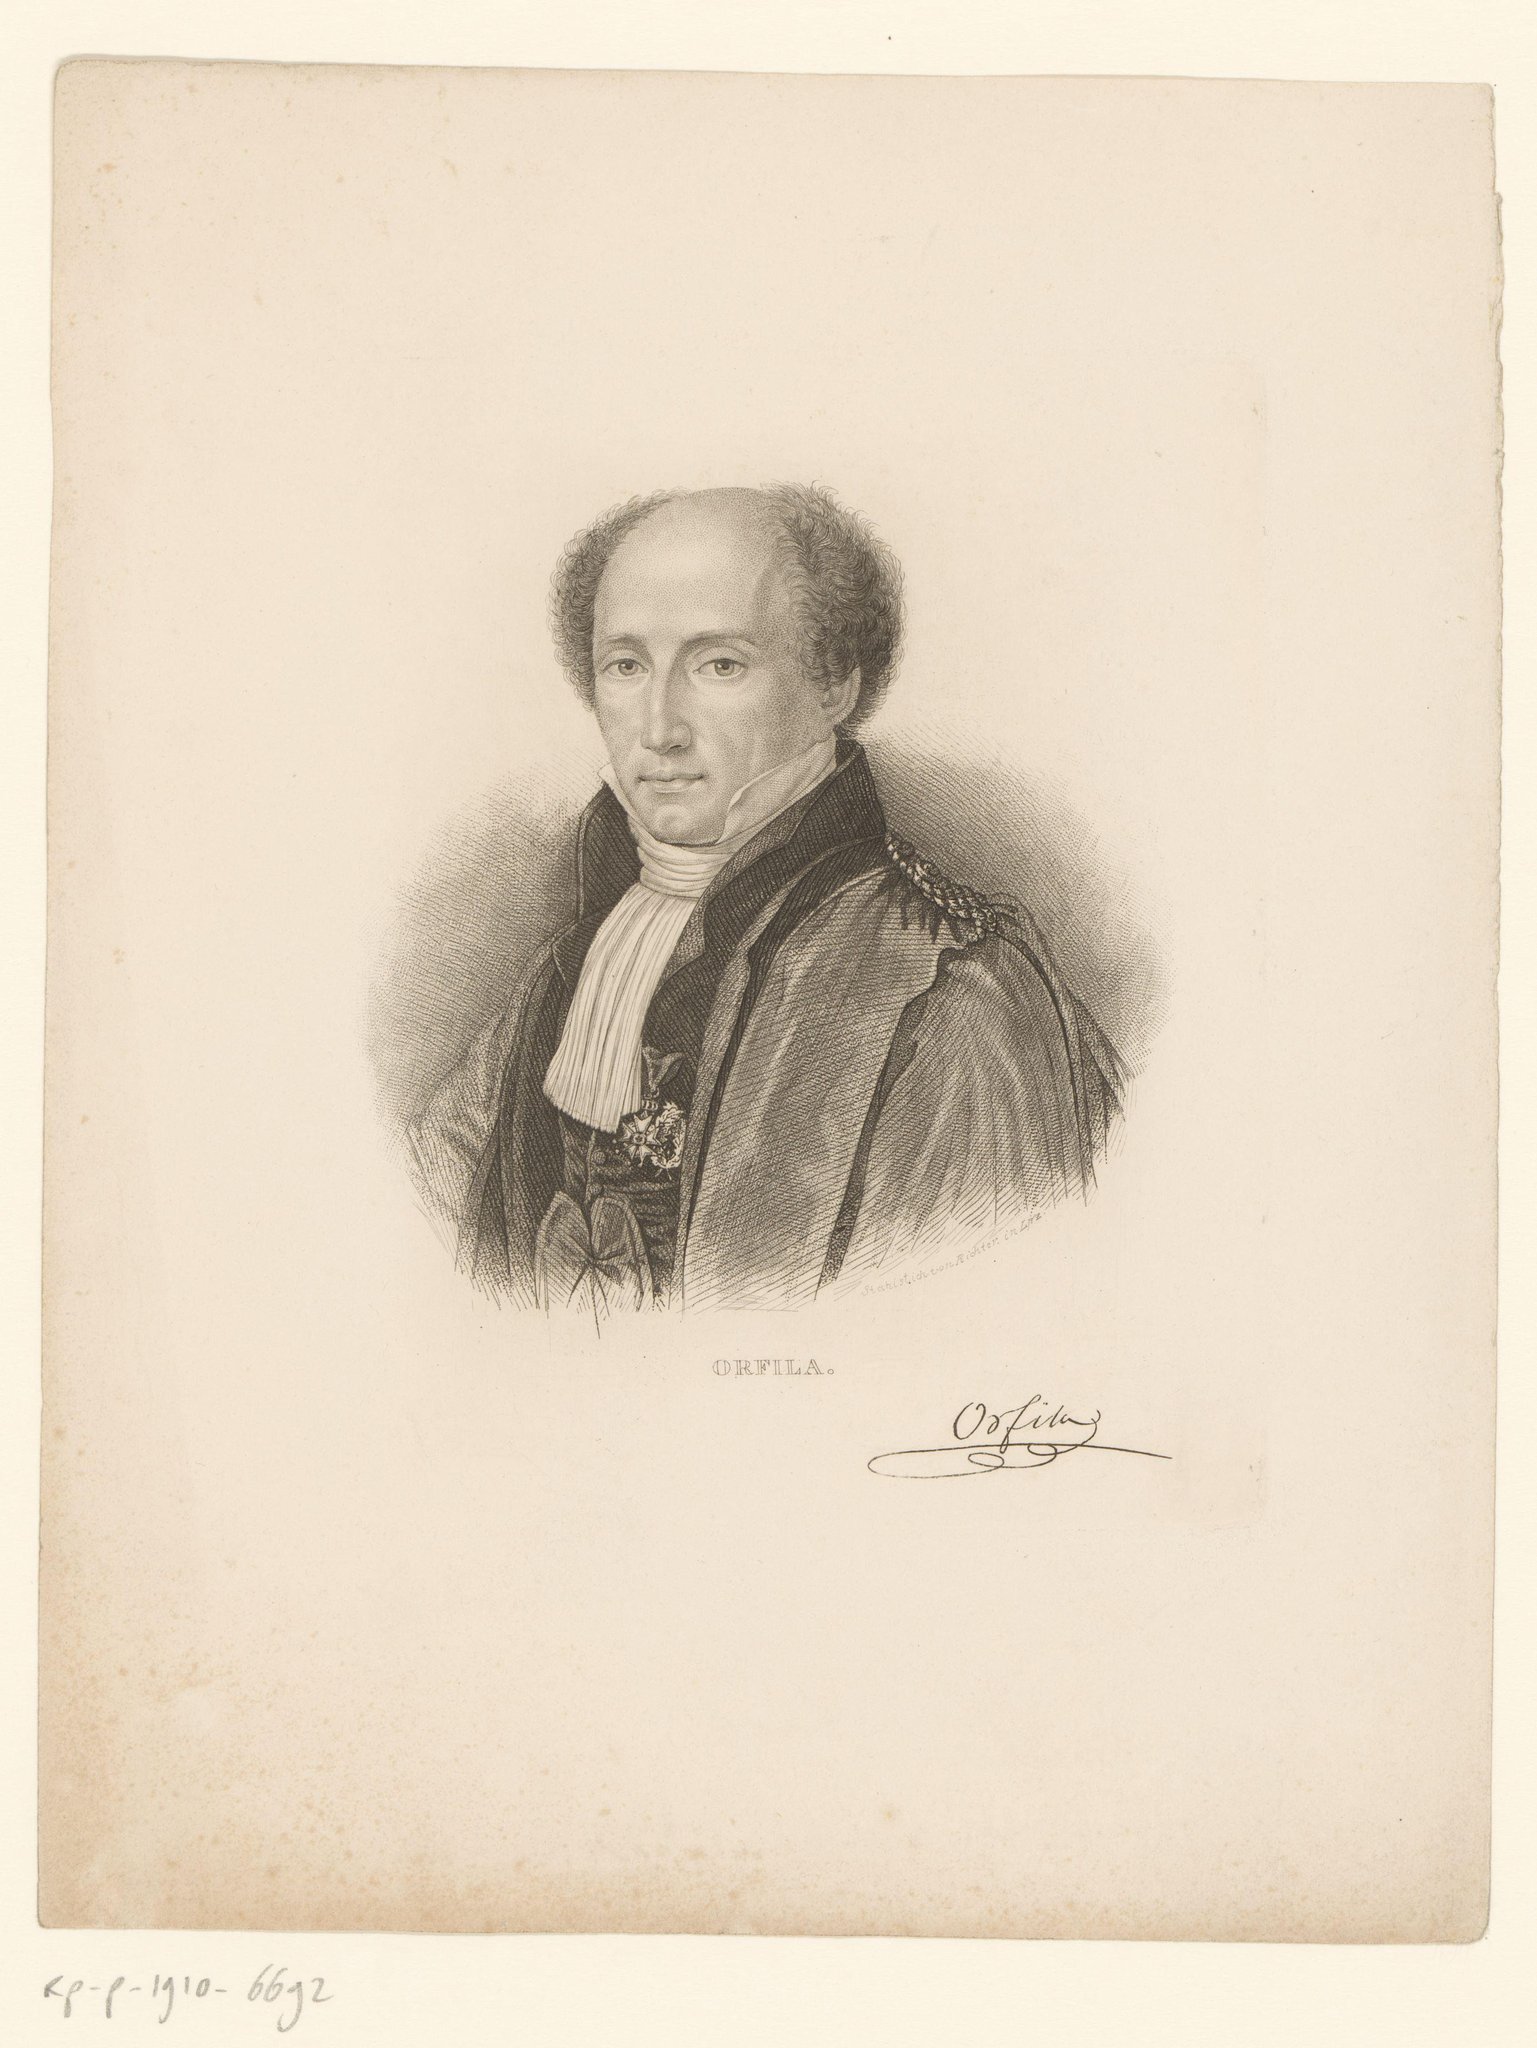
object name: print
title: Portret van Mathieu Orfila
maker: f. richter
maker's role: print maker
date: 1800-1899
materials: paper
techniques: roulette, engraving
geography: leipzig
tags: historical persons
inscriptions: collector's mark: Lugt 2228